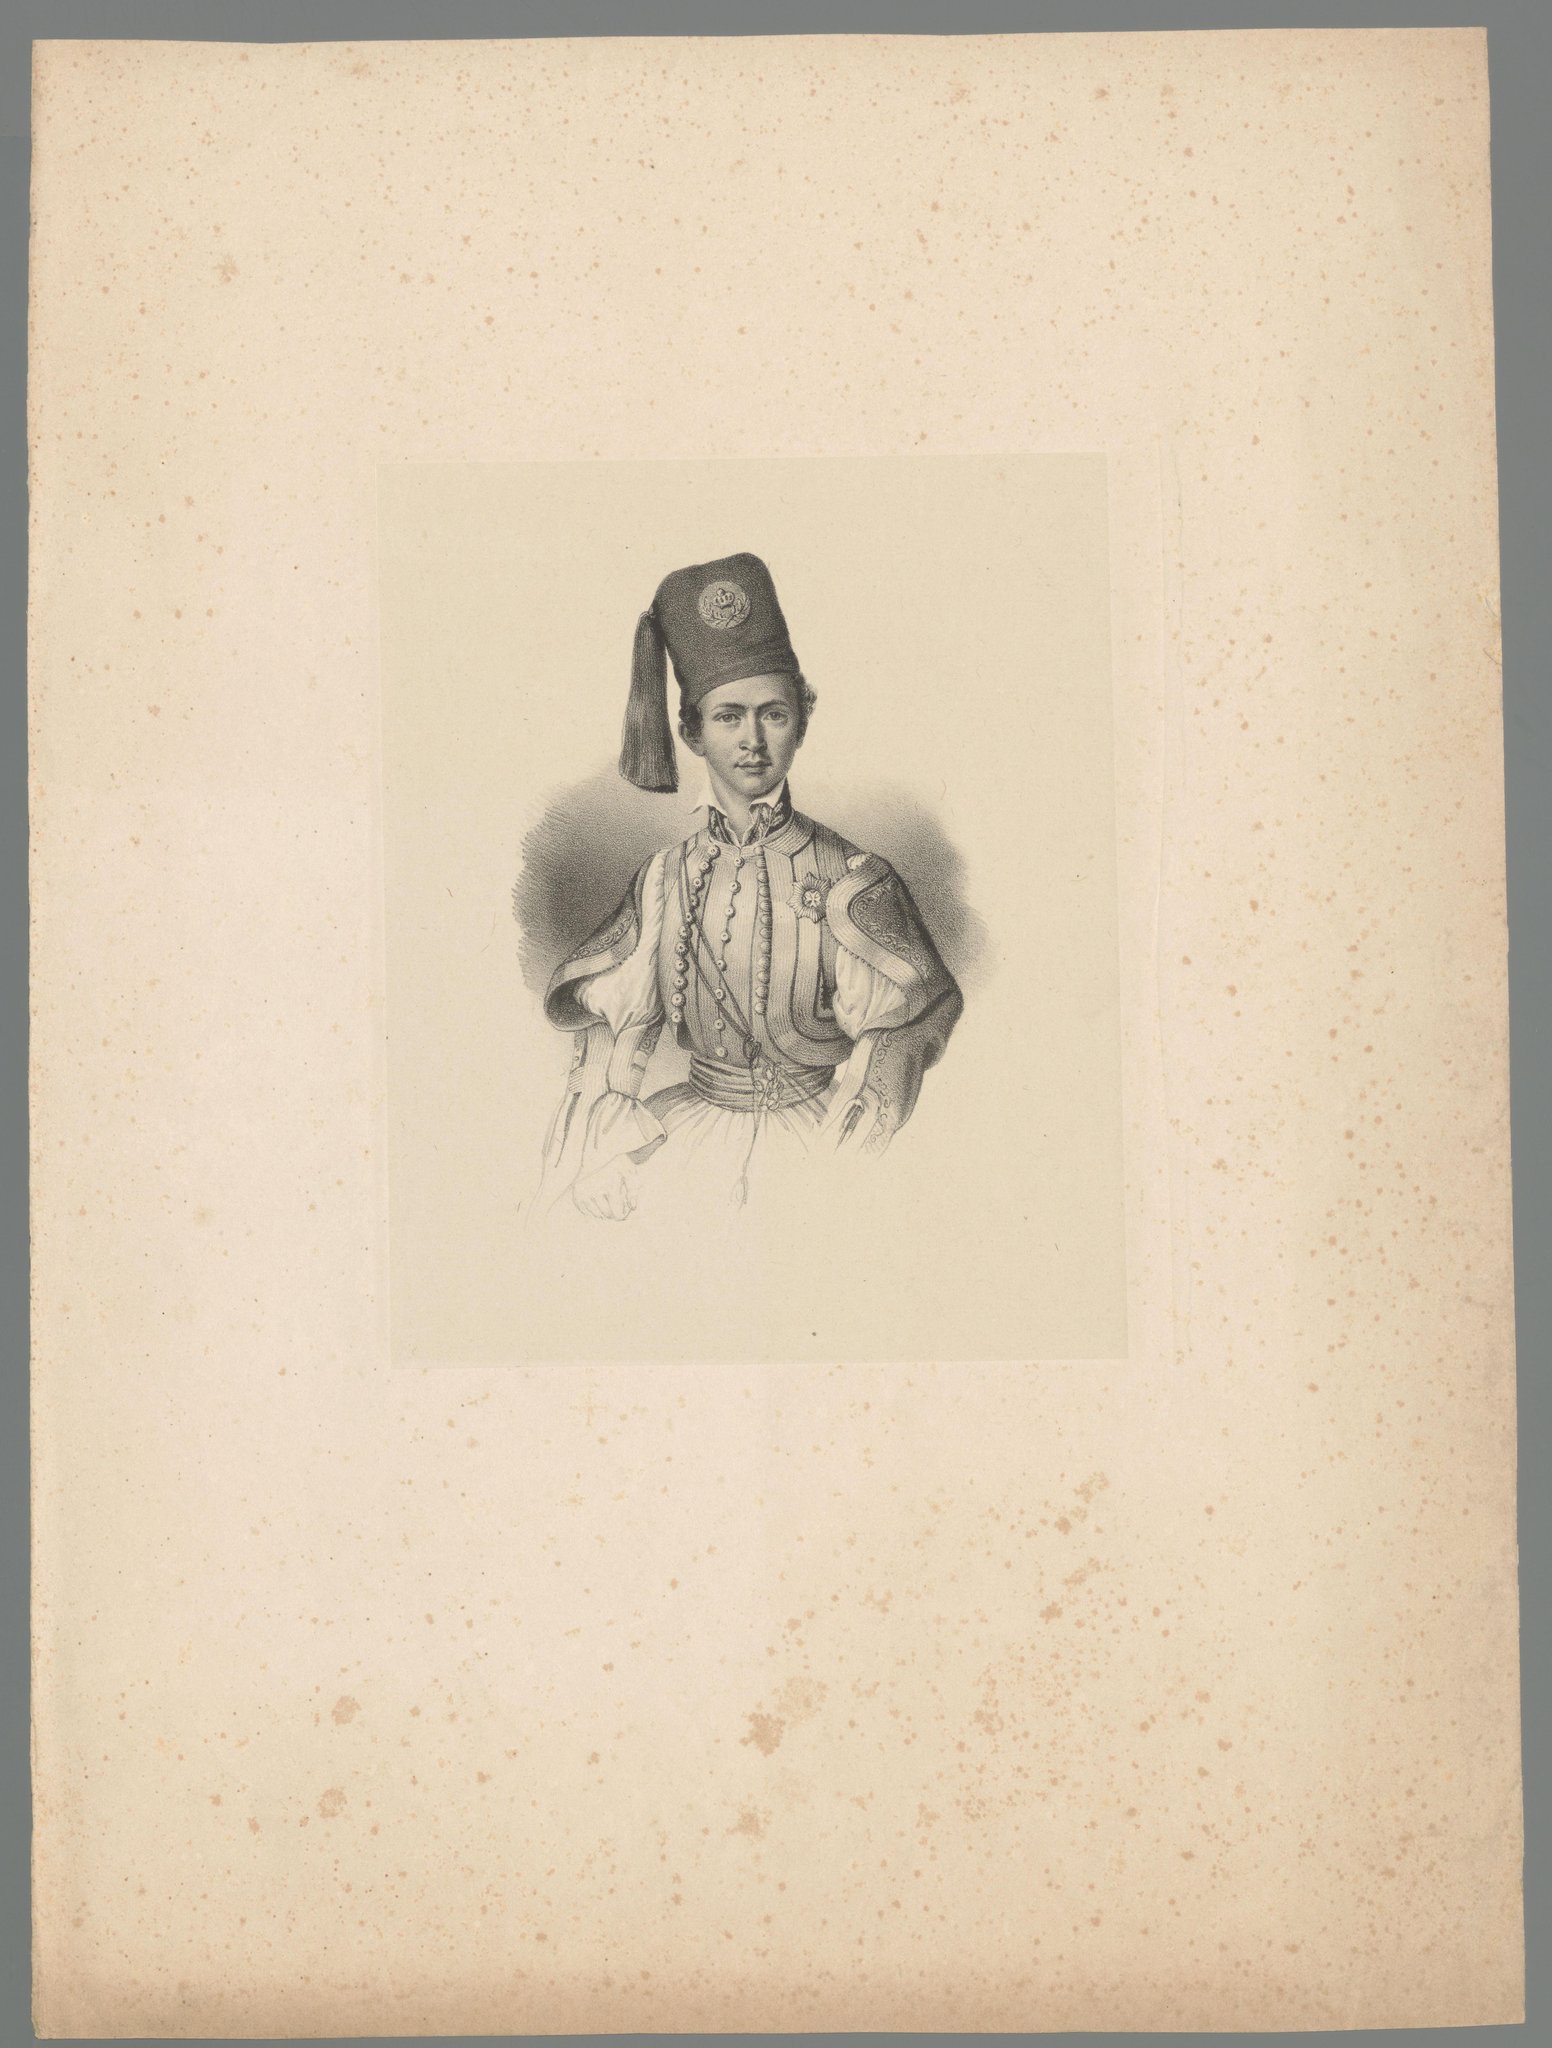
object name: print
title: Portret van een onbekende man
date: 1820-1875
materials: paper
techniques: lithograph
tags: head-gear, adult man, historical persons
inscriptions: collector's mark: Lugt 2228